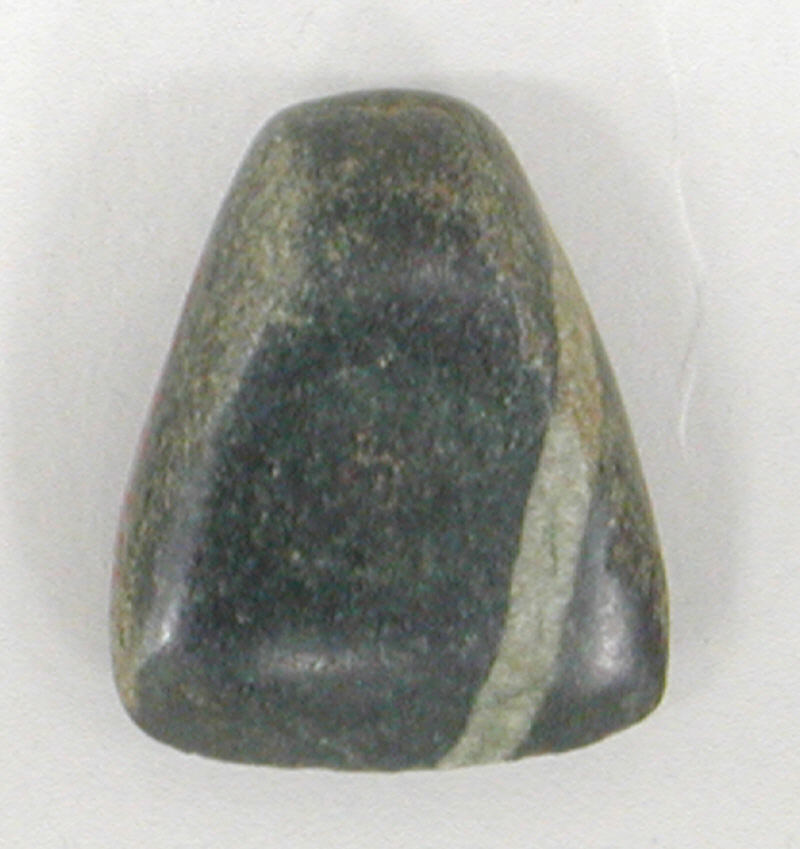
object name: chisel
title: Stone Chisel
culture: maya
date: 1501-1600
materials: stone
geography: guatemala